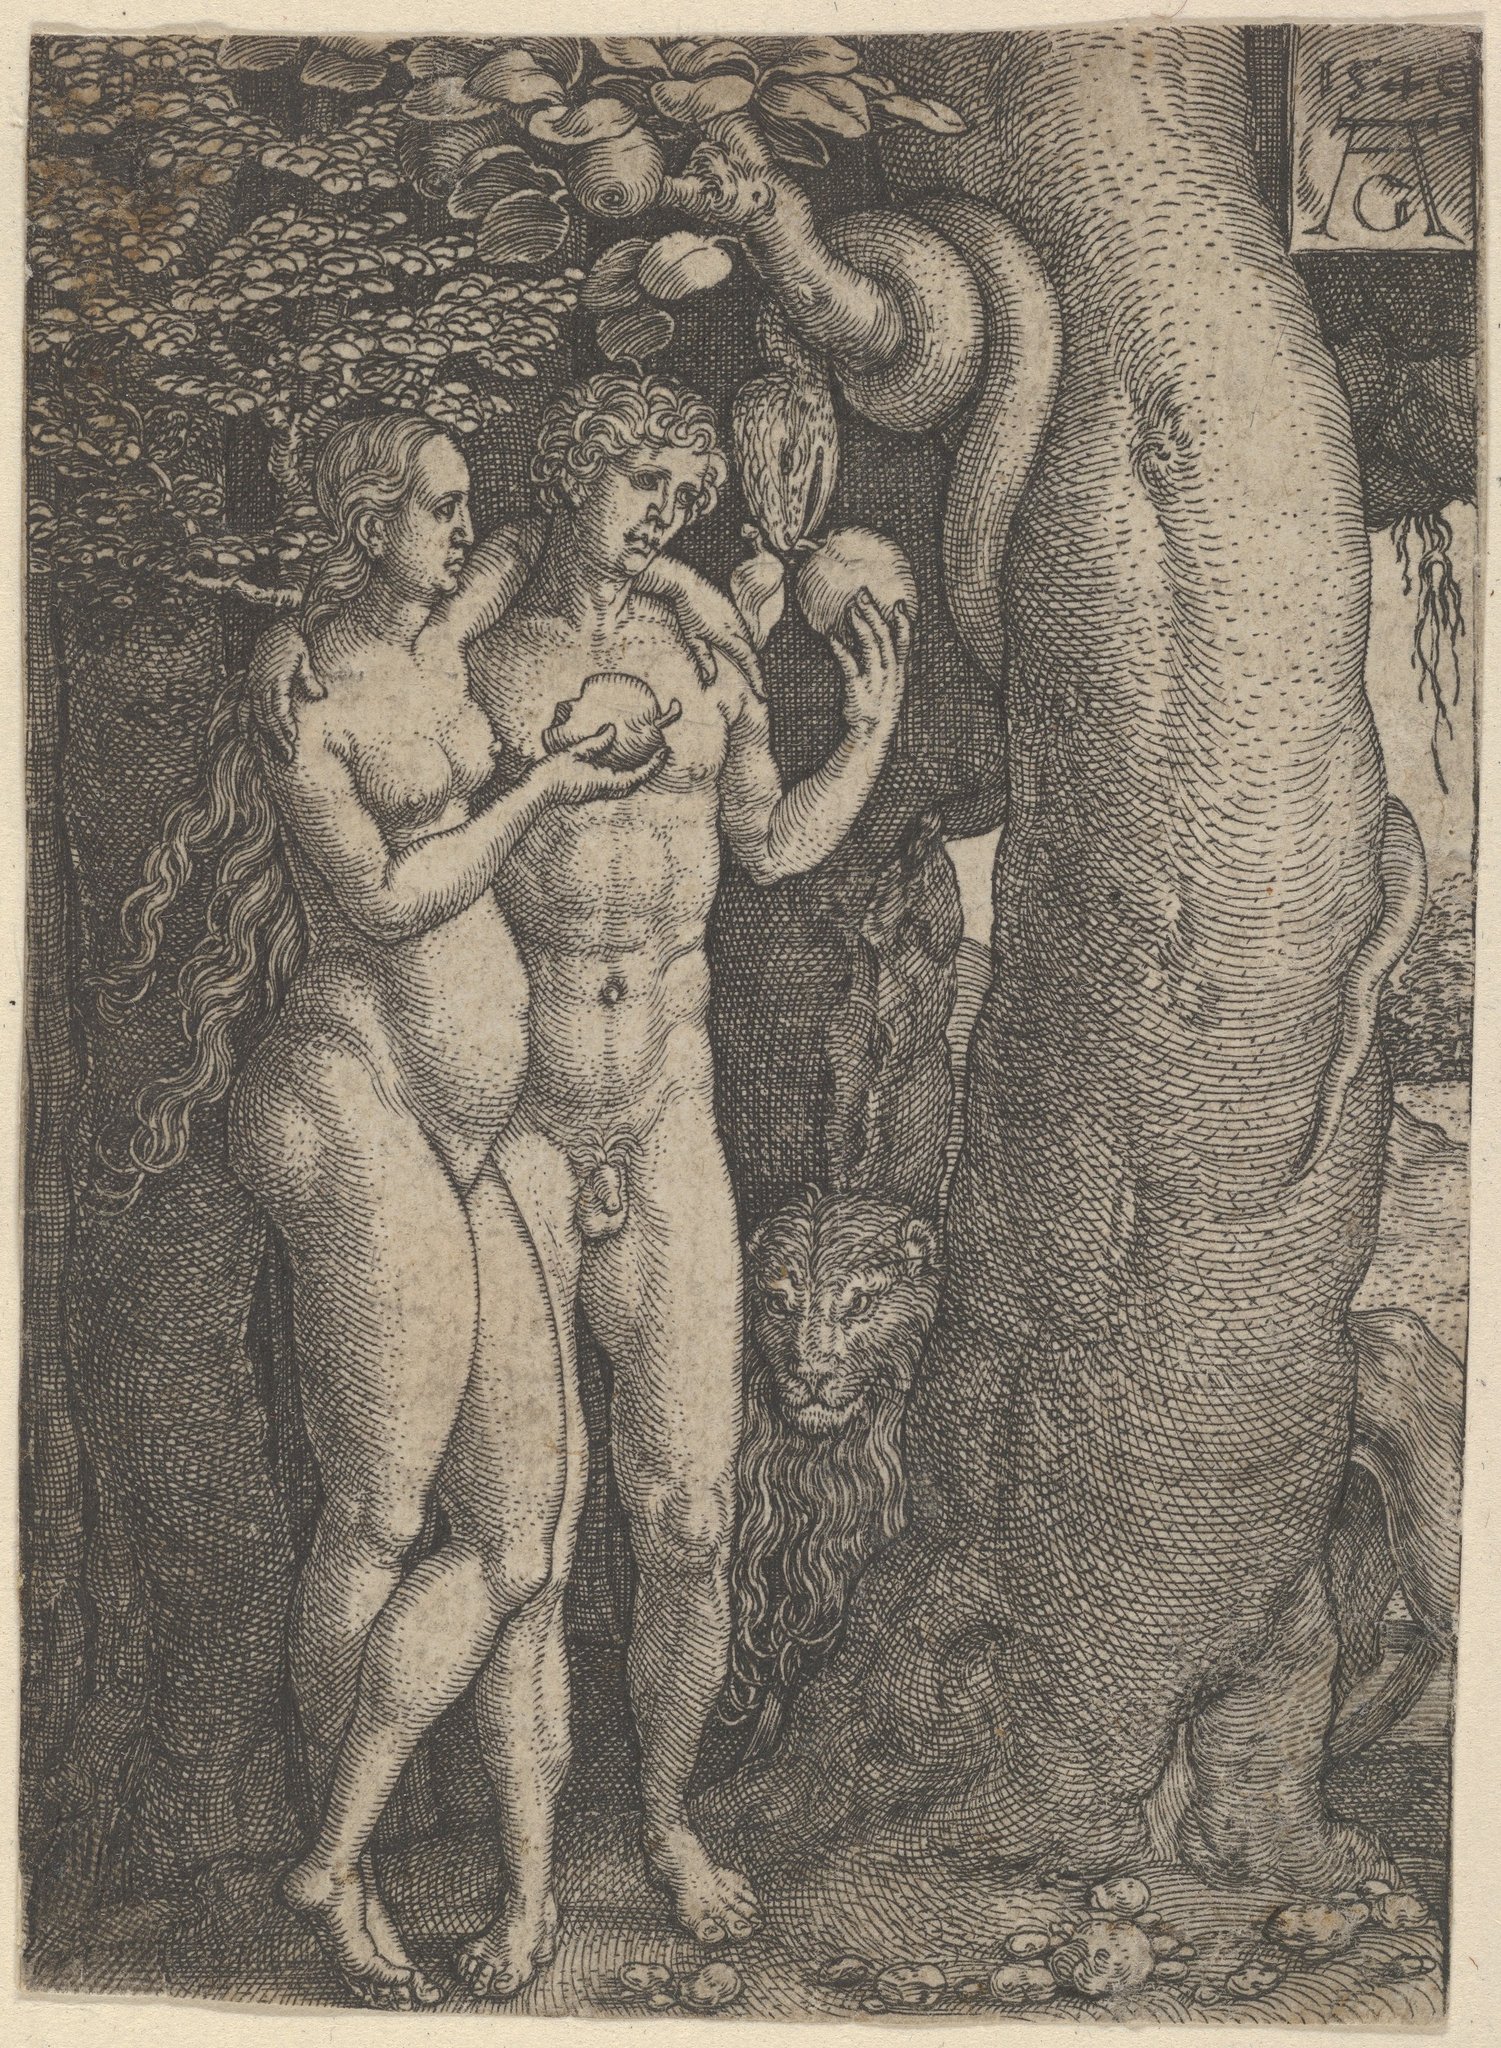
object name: print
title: The Temptation of Adam and Eve, from "The Story of Adam and Eve"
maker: heinrich aldegrever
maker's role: artist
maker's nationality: german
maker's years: 1502-1561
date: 1540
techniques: engraving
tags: fruit,lions,snakes,adam,eve